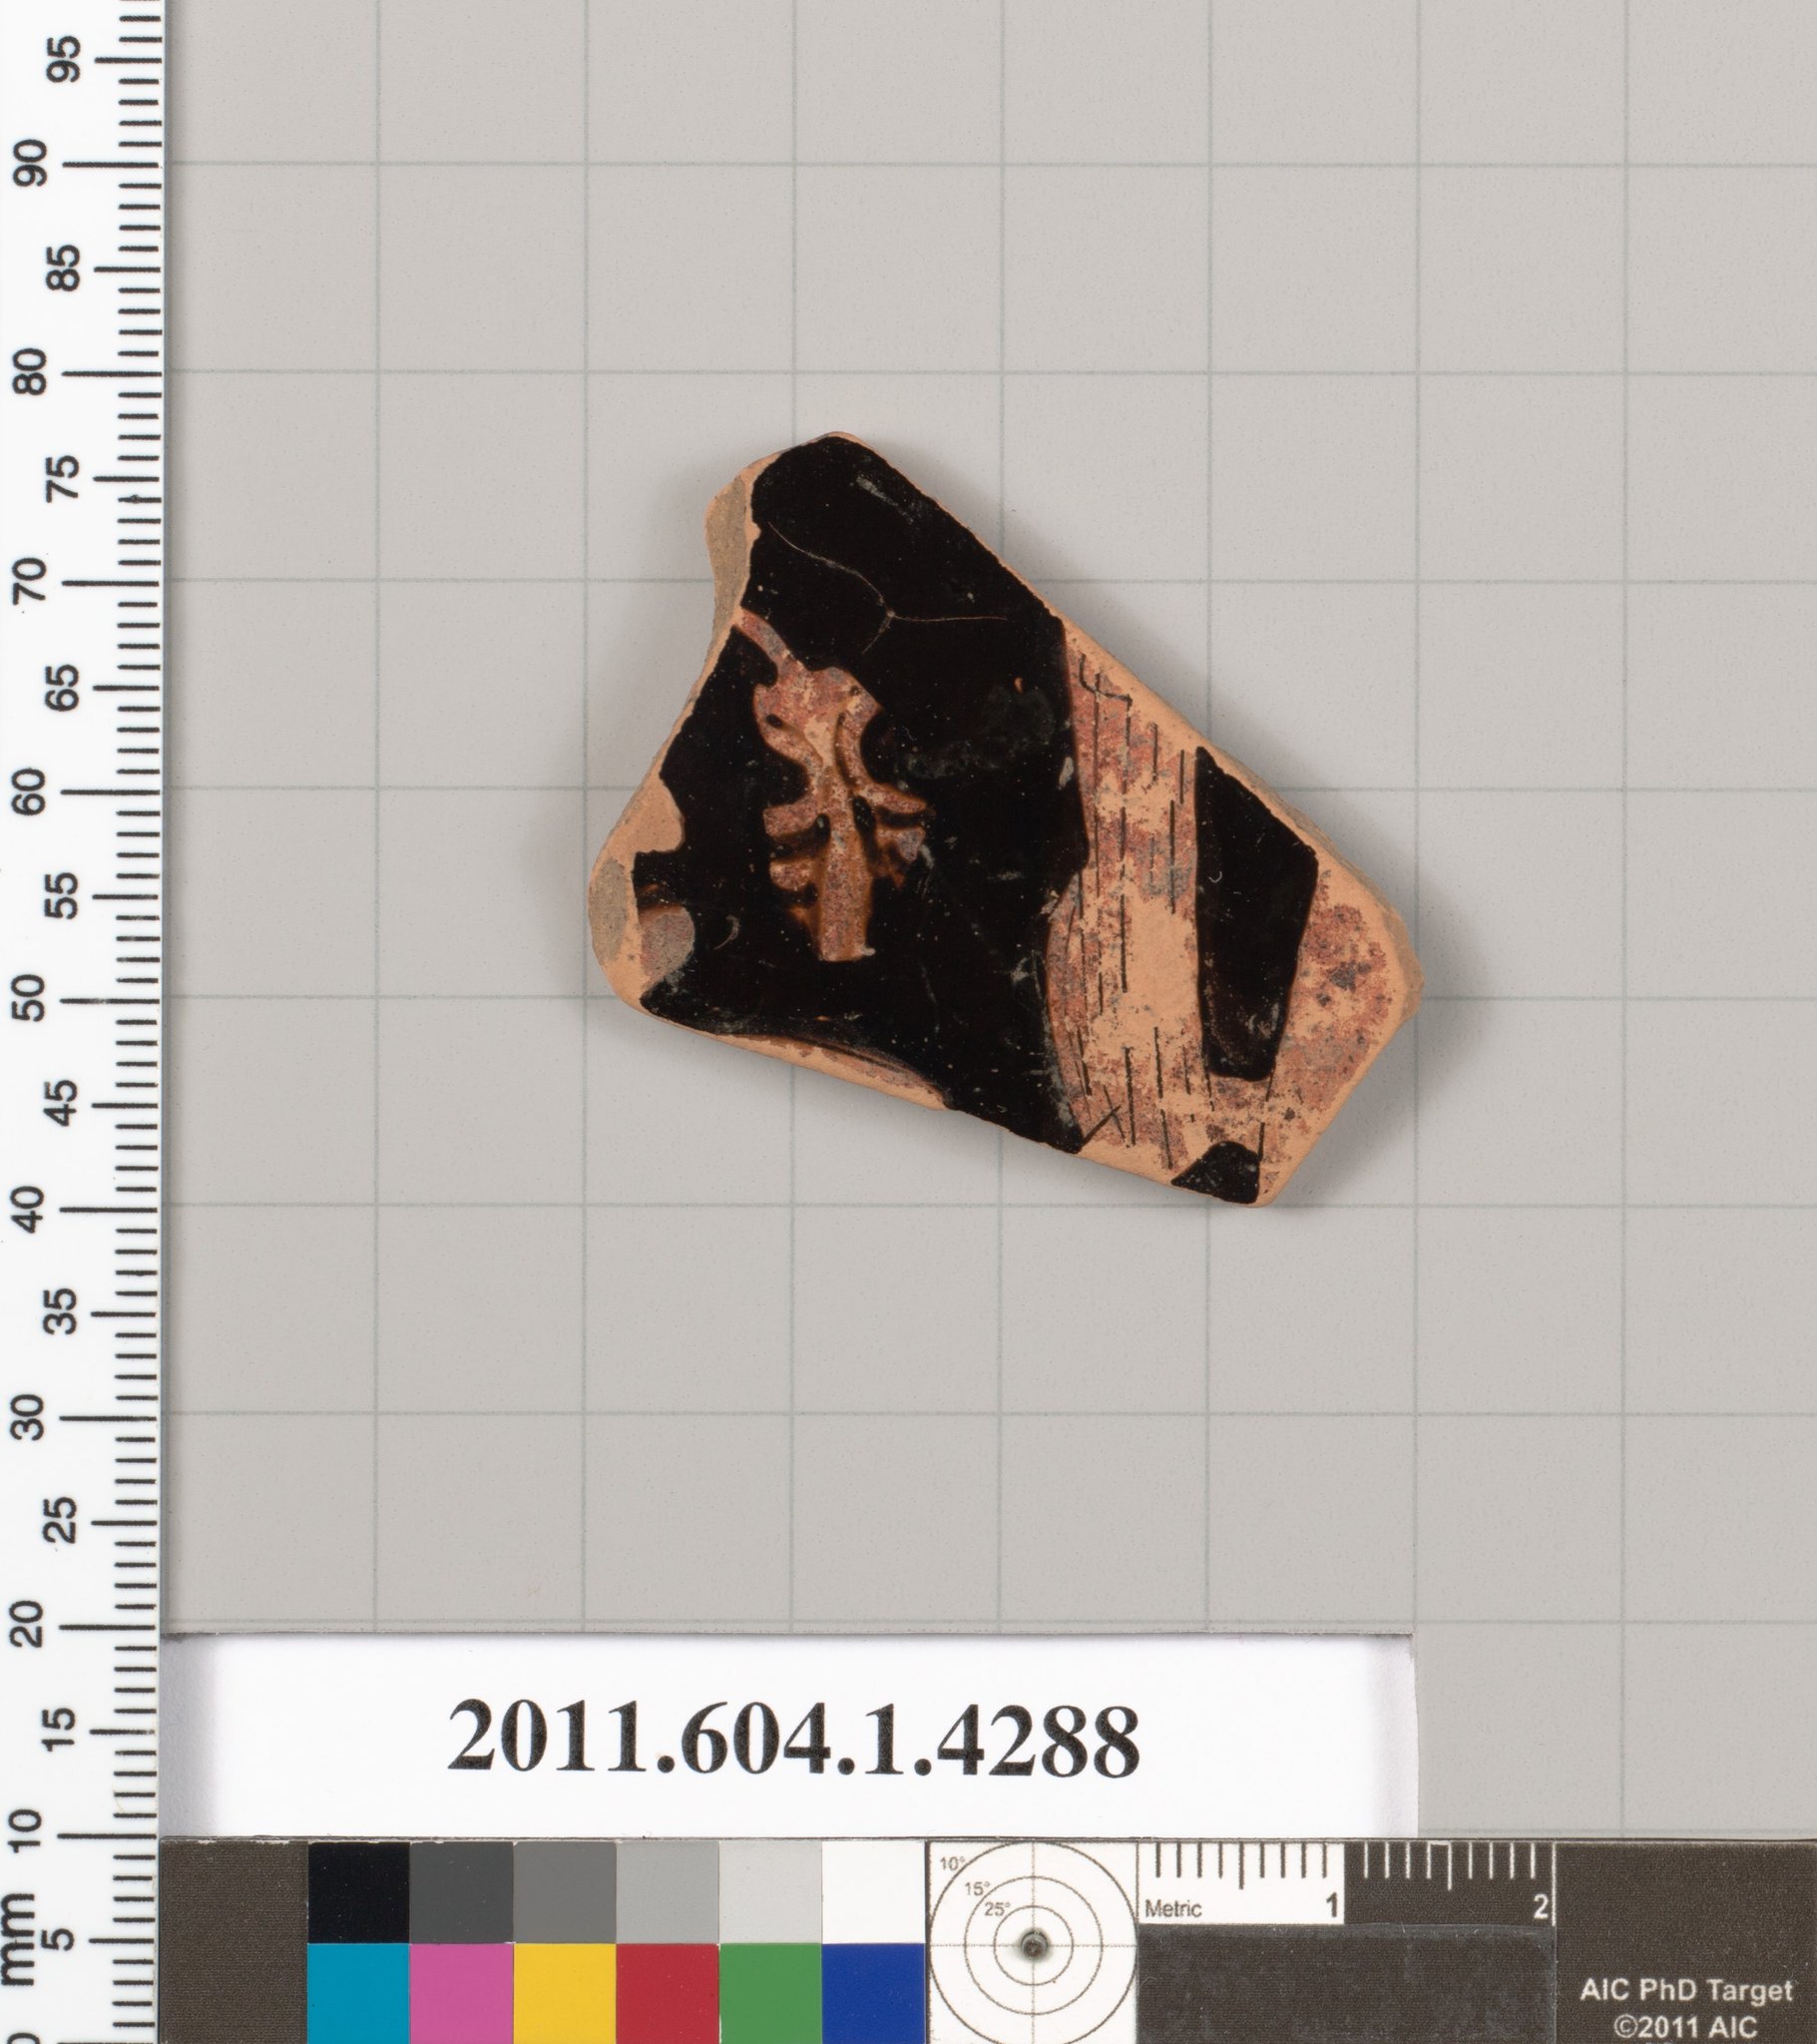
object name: kylix fragment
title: Terracotta fragment of a kylix (drinking cup)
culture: greek, attic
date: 475-451 BCE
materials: terracotta